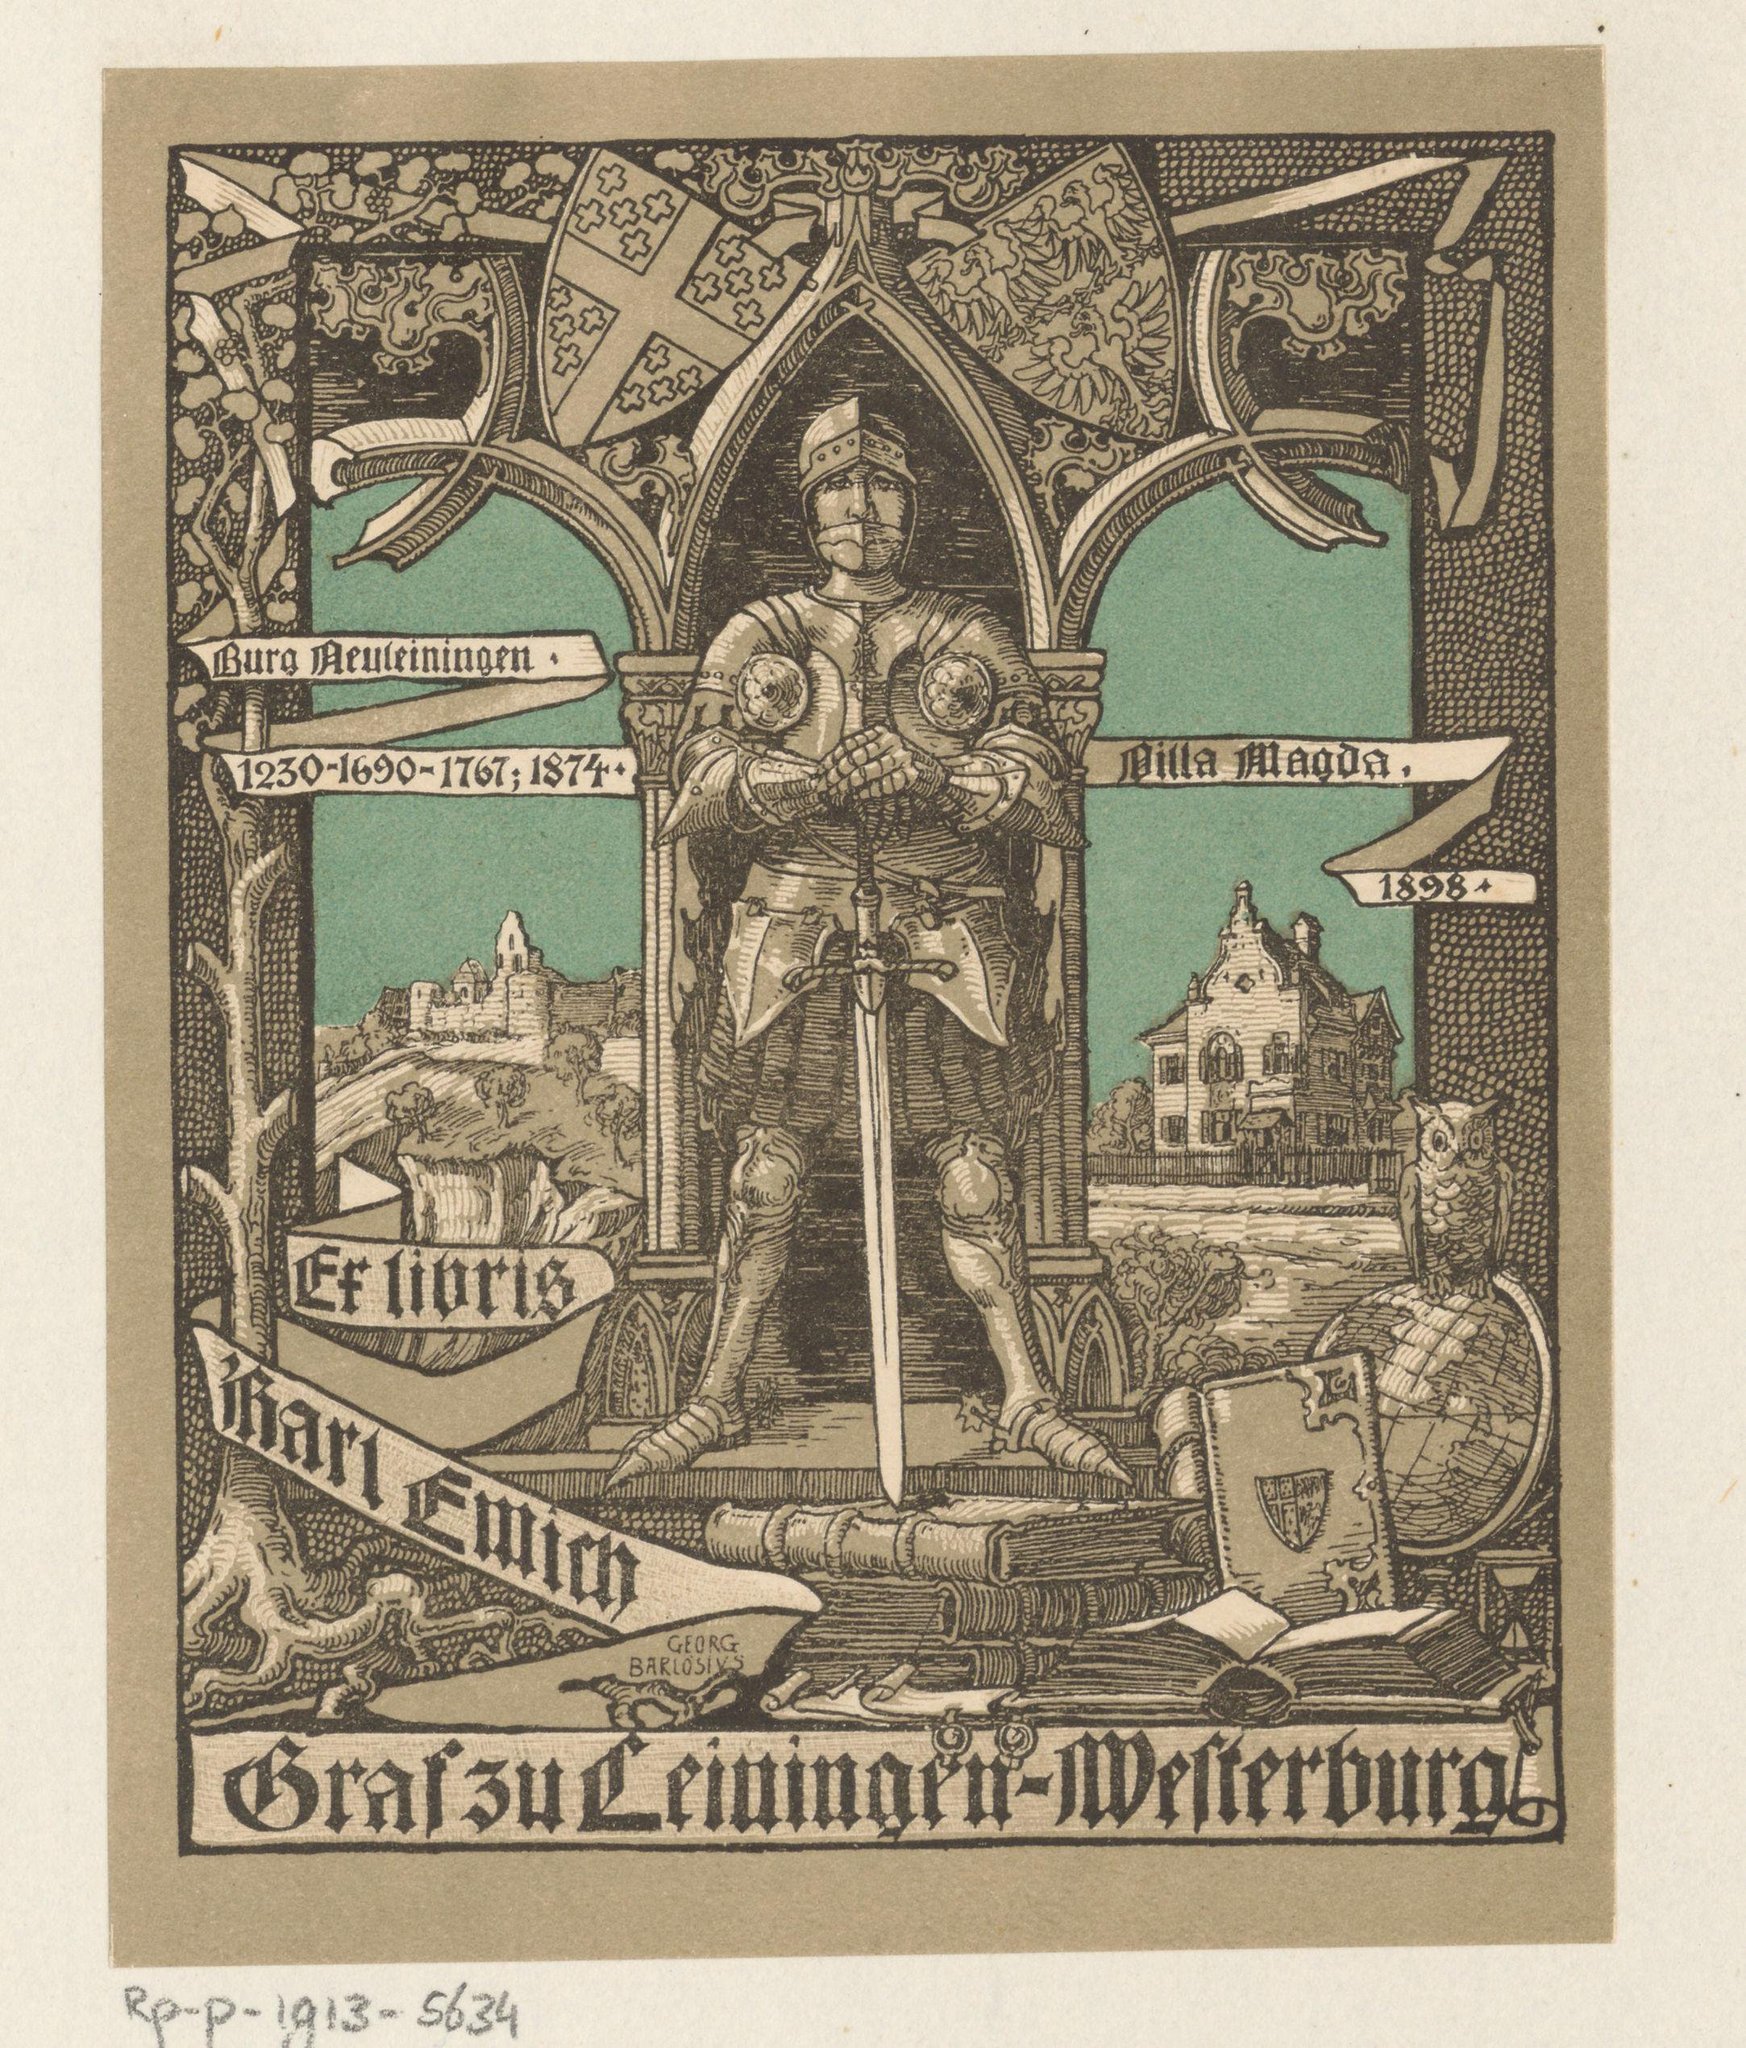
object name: photomechanical print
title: Ex libris van Karl Emich Graf zu Leiningen-Westerburg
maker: georg barlösius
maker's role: print maker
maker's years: 1864-1908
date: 1898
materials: paper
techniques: printing block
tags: knight, armorial bearing, heraldry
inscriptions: collector's mark: Lugt 2233